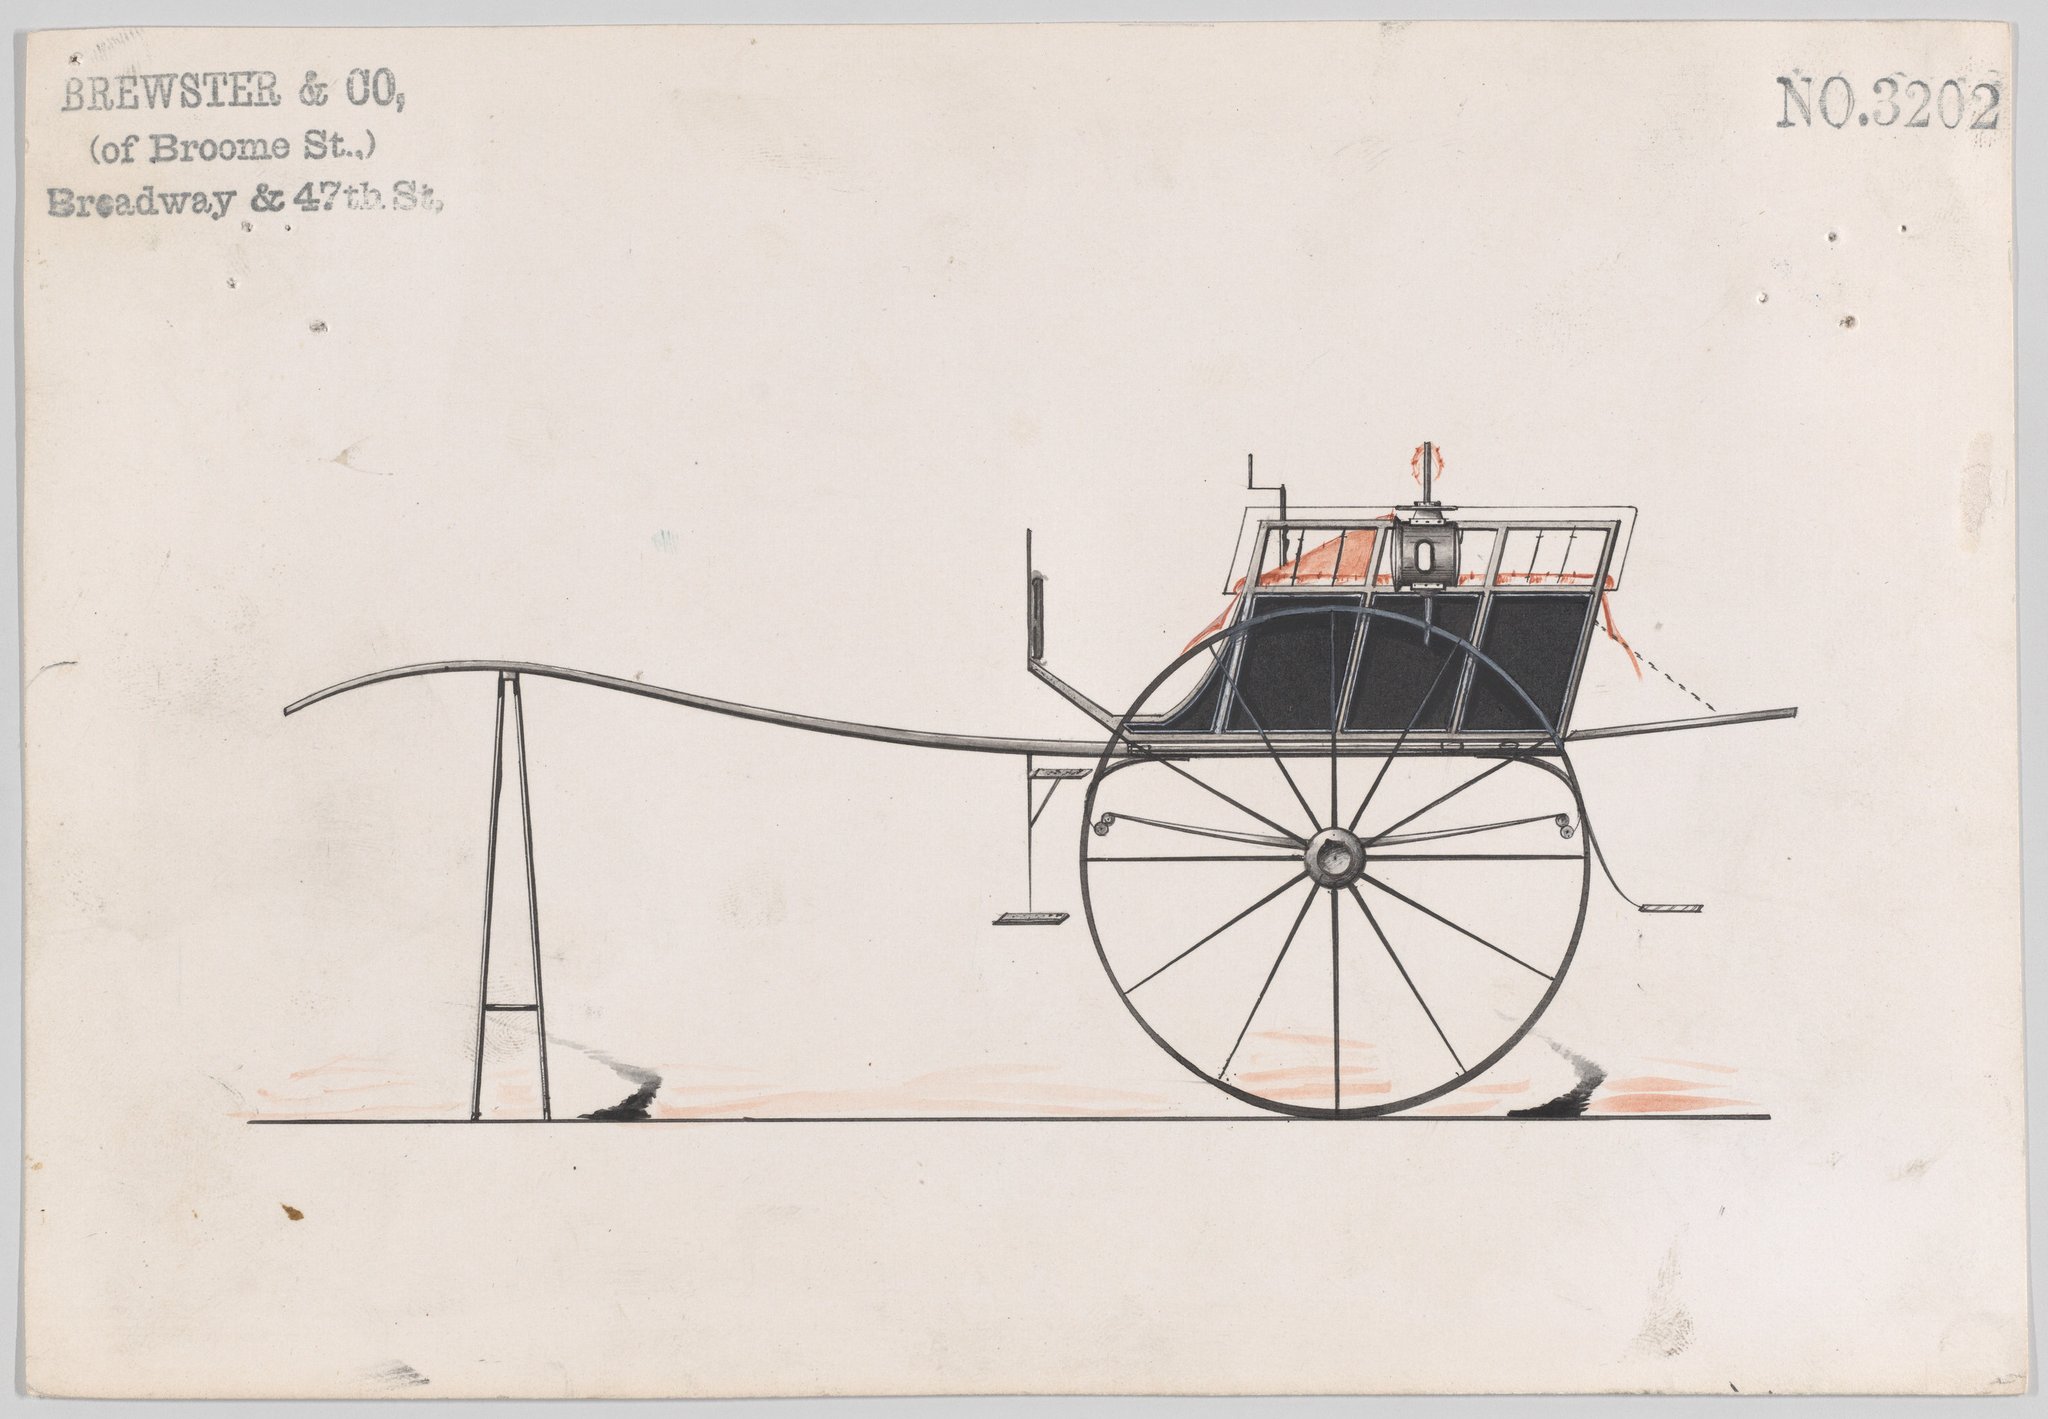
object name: drawing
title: White Chapel Cart # 3202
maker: brewster & co.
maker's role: manufacturer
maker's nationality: american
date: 1876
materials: gouache, gum arabic, ink, watercolor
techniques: pen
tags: carriages